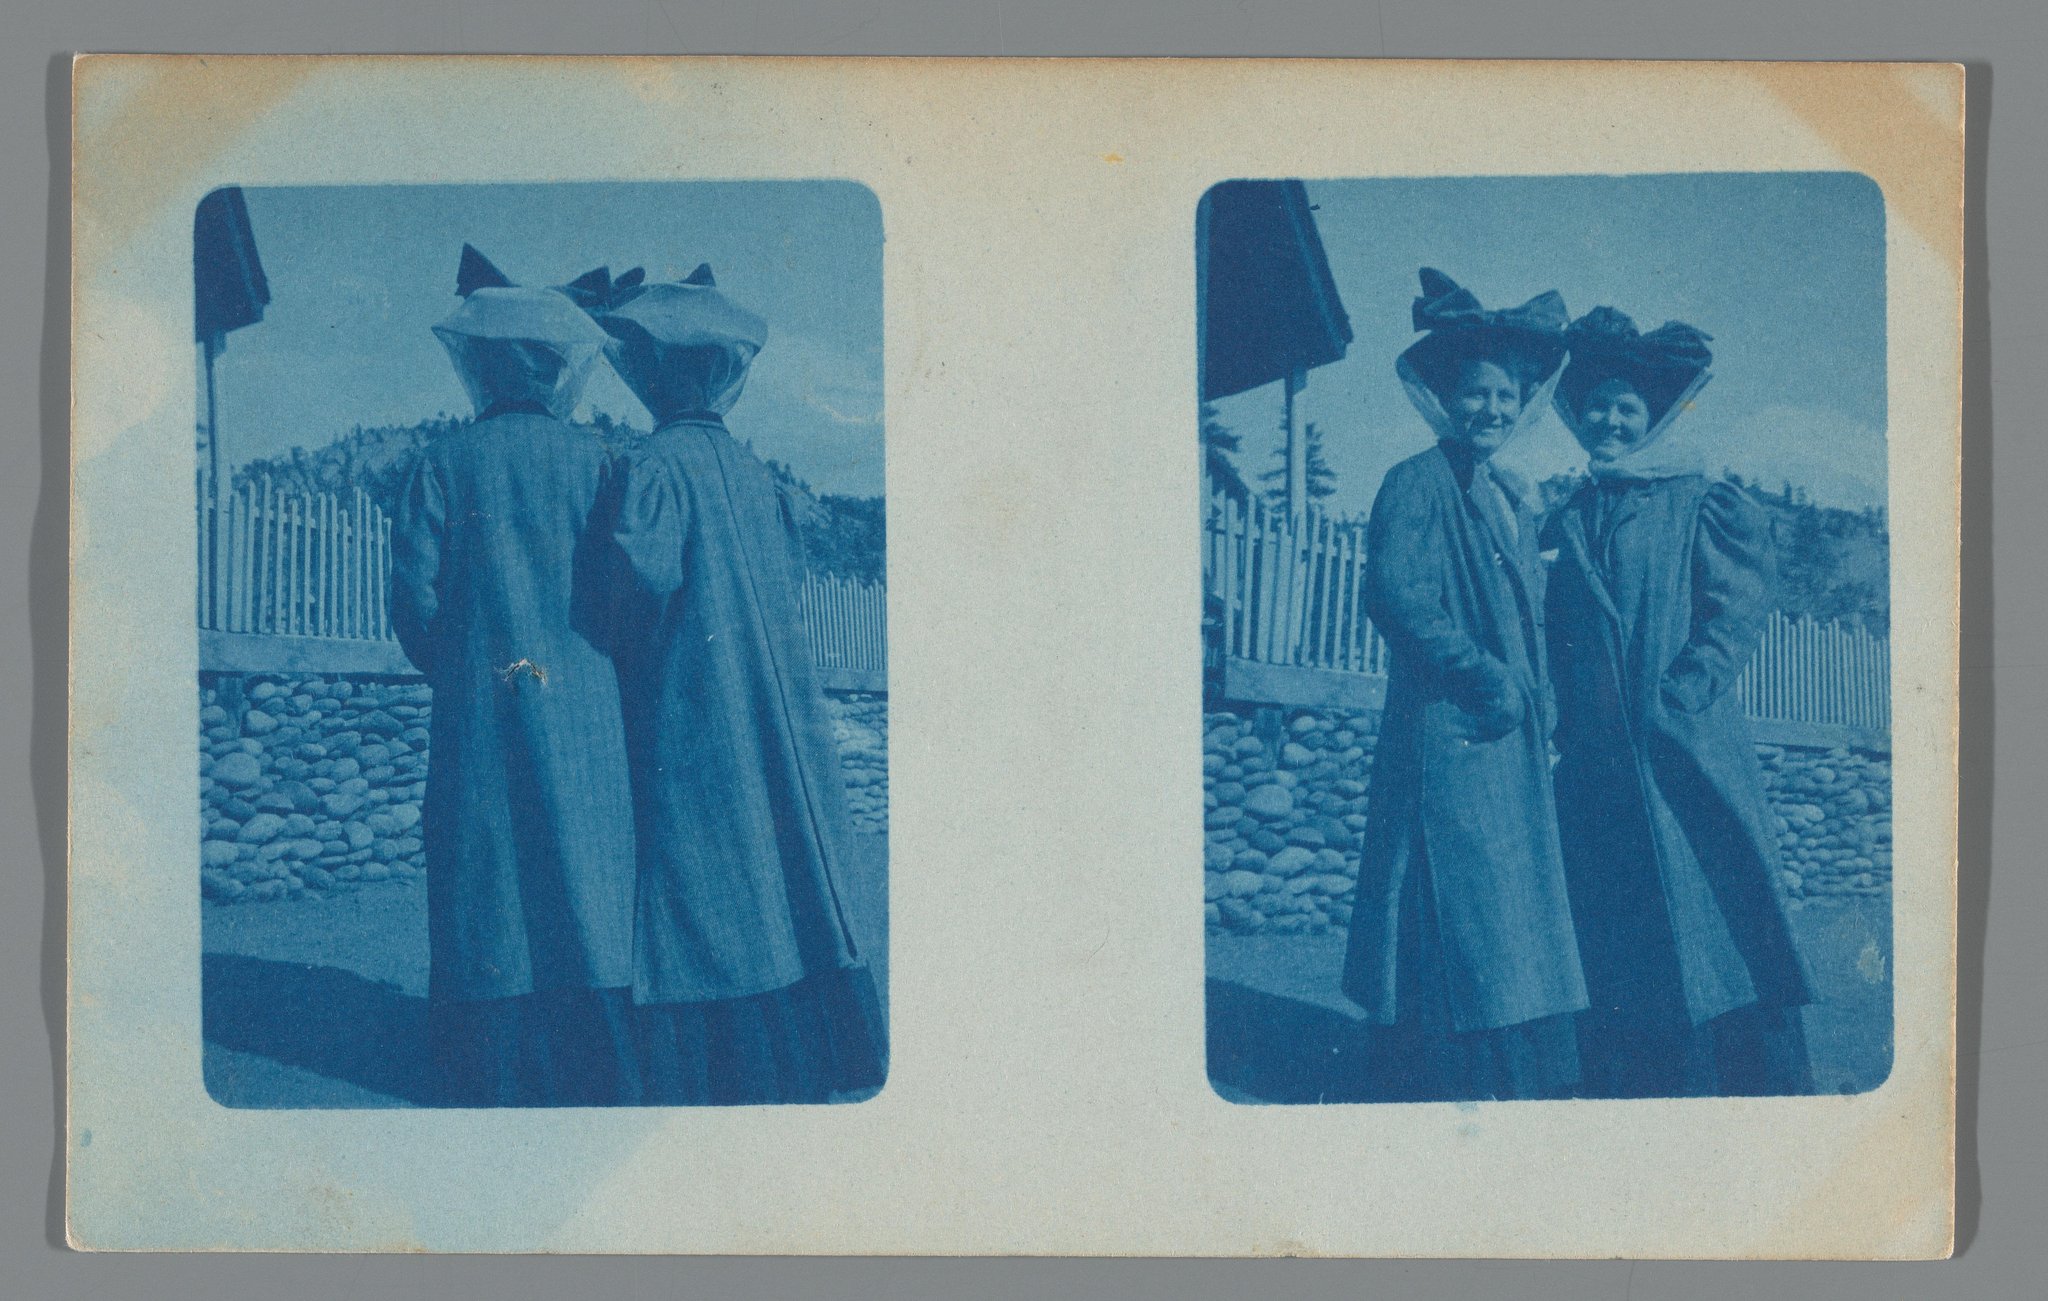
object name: photograph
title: Twee foto’s van twee vrouwen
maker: Anonymous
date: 1908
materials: paper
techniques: cyanotype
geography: united states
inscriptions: inscription: ‘Dear Rosena / This is just / a sample of the pictires / that I am going to take. / I printed six cards this / morning. Now we can have / our picture taken any time / we want to. I like my Kodak / just fine. I have only taken / one picture but I am going to / take some more in a little while. / Margaret. // Miss Rosena Sweeney / Golden . Colo.’